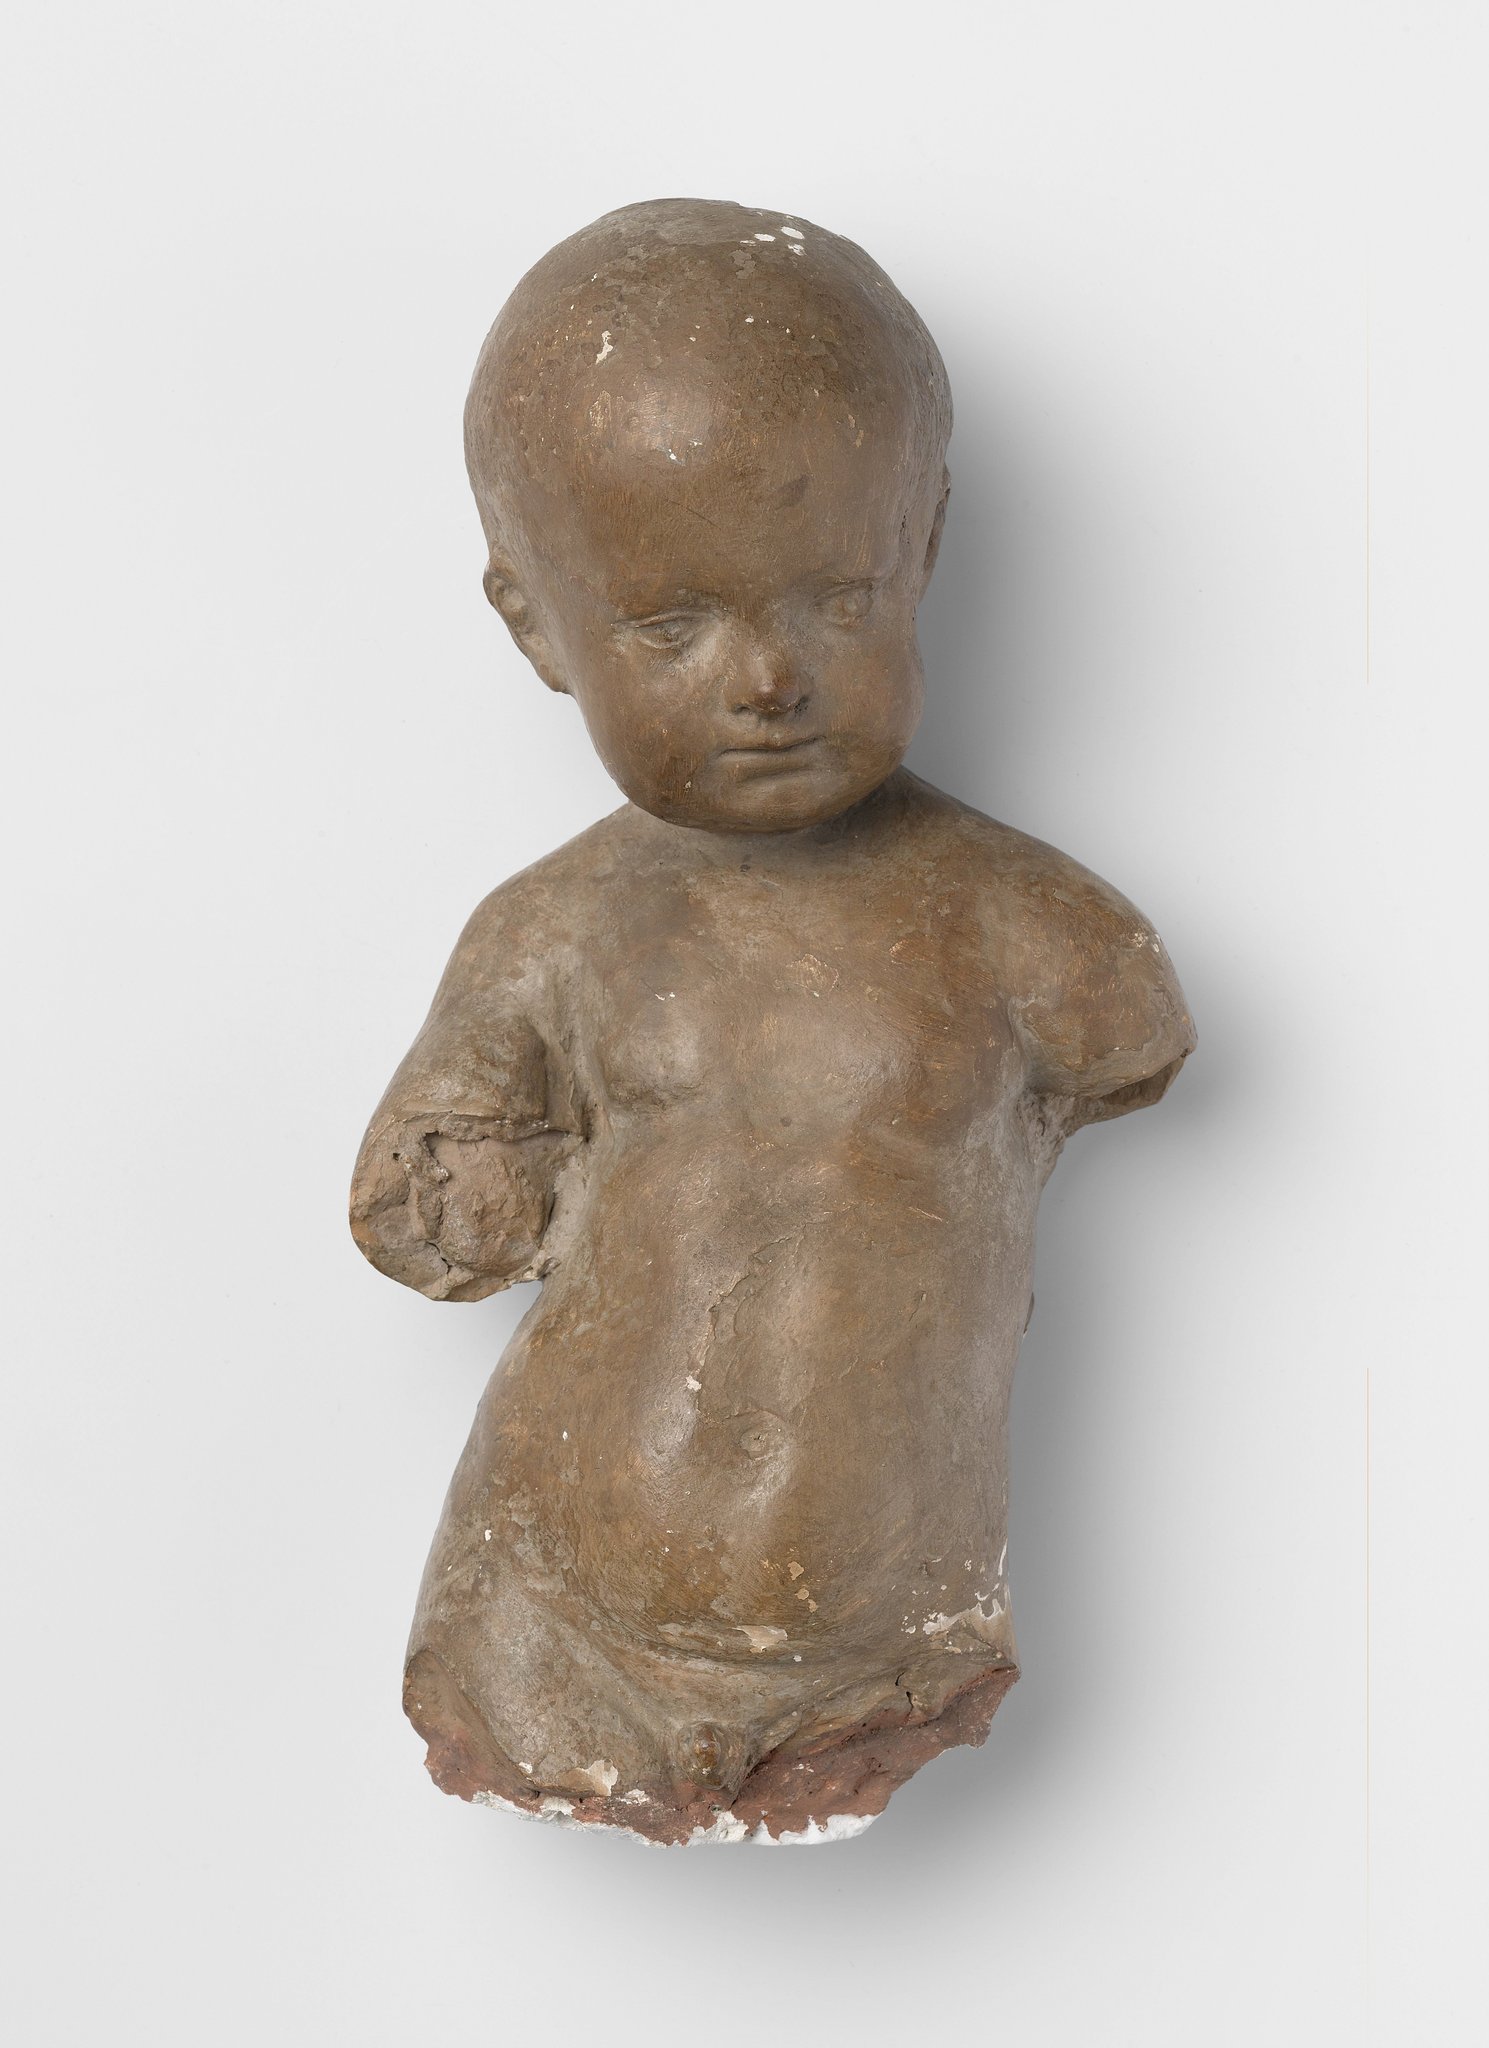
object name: sculpture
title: Christuskind met bijbehorende marmeren sokkel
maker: Anonymous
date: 1500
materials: terracotta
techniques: modeling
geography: florence